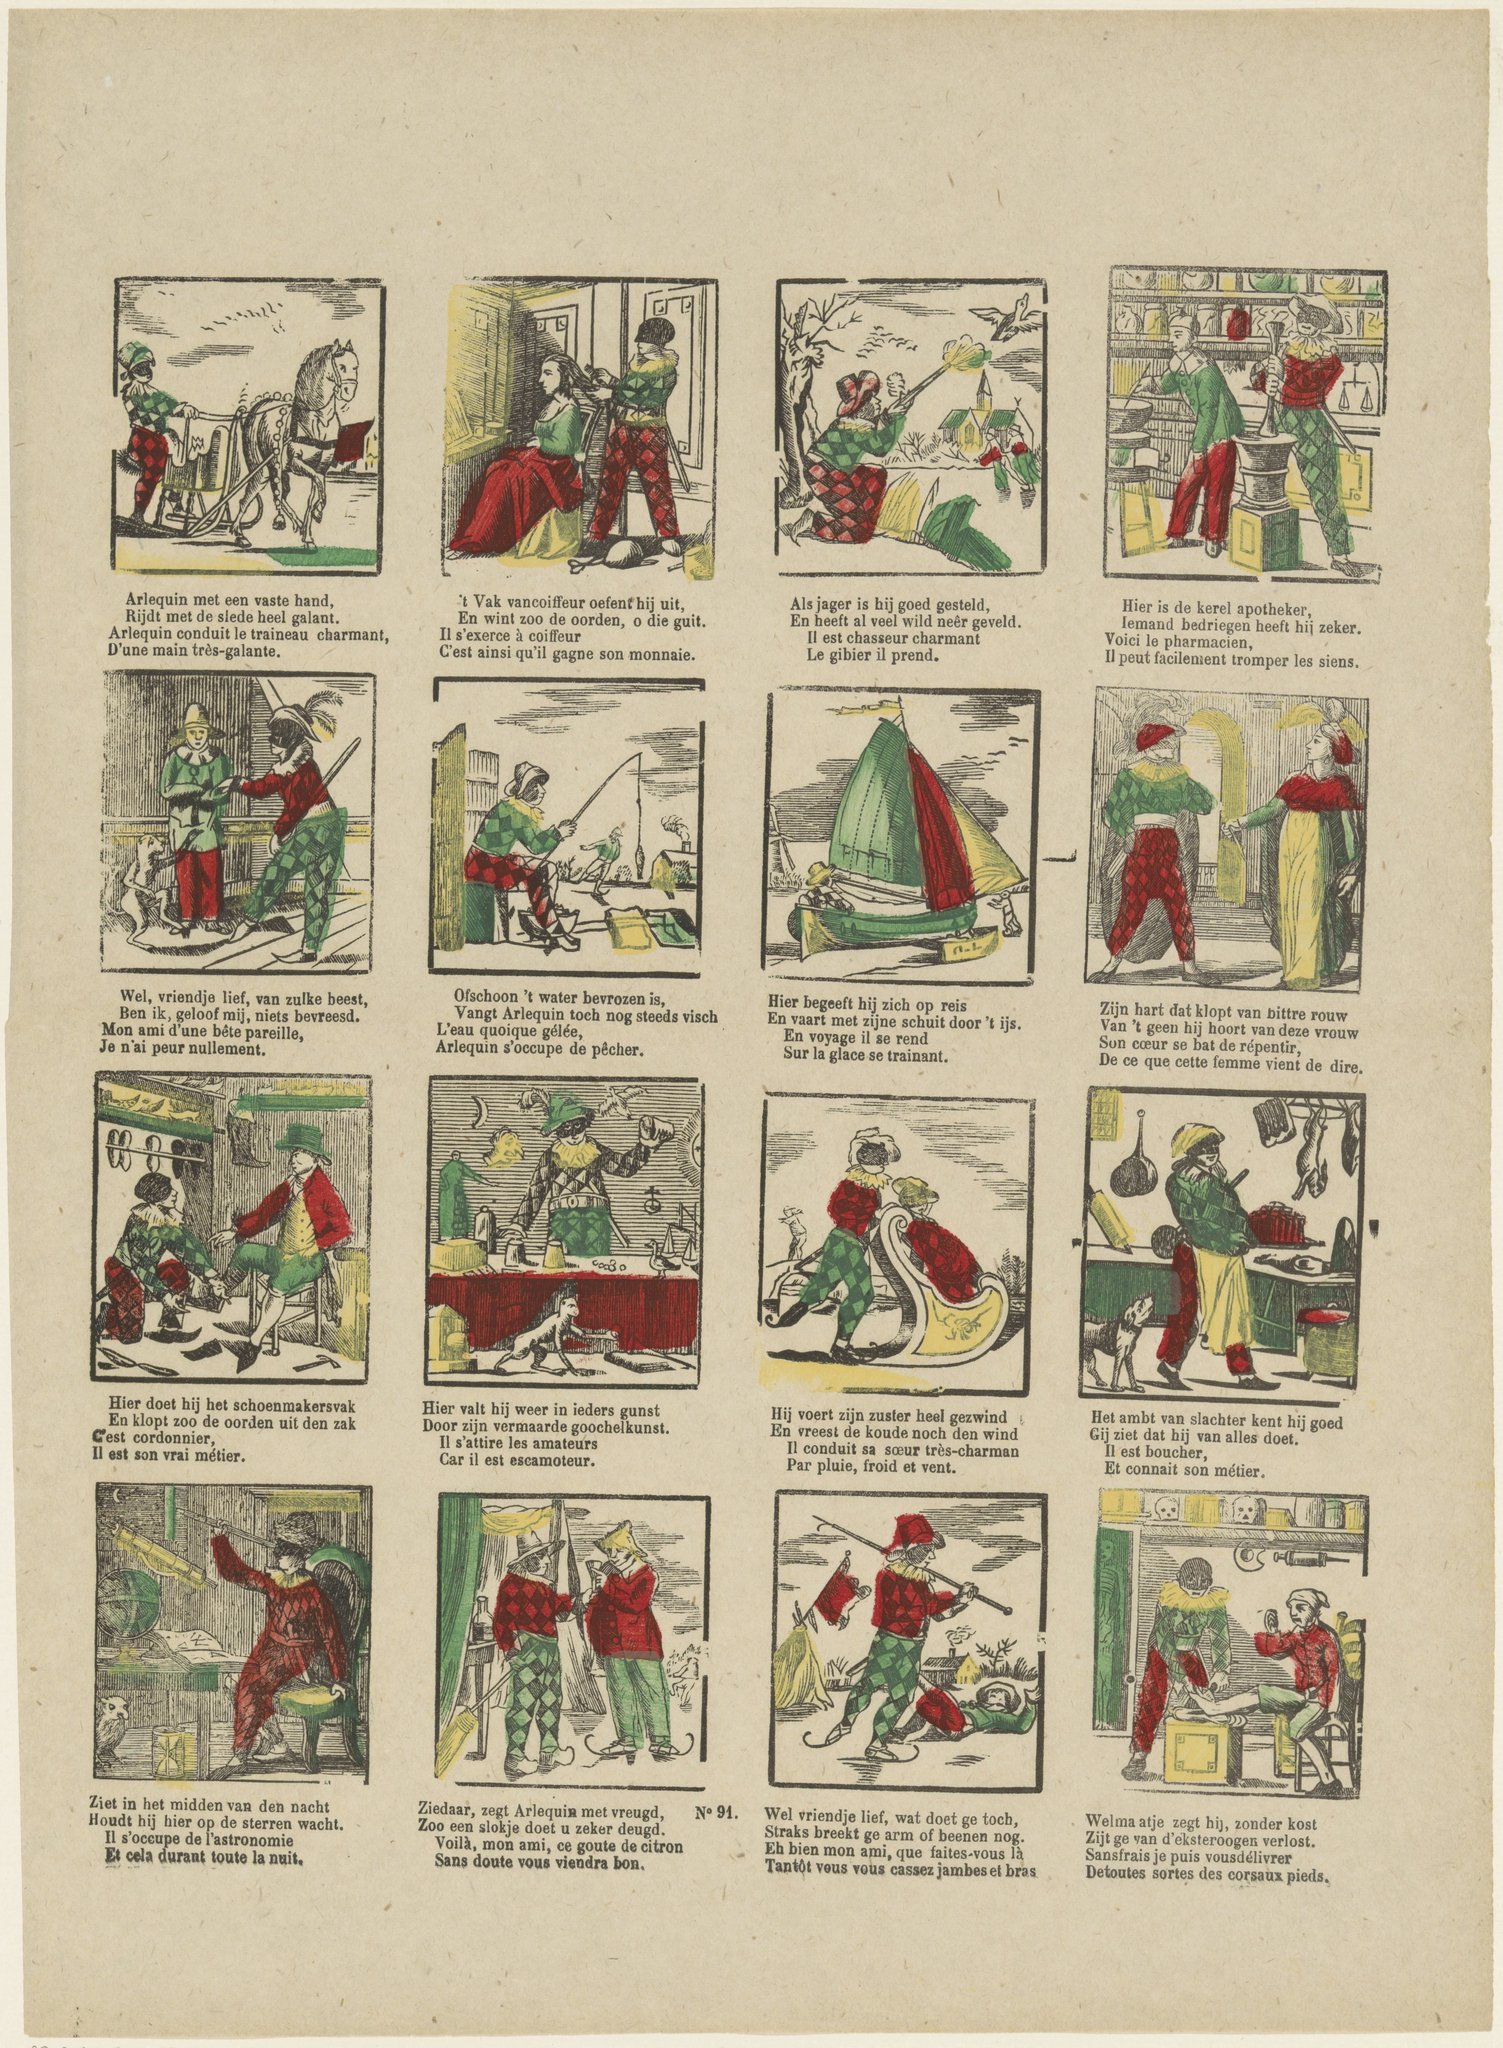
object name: print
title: Harlekijn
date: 1866-1902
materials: paper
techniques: colour, letterpress printing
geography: turnhout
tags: types in 'commedia dell'arte': harlequin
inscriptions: collector's mark: Lugt 2760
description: Blad met 16 voorstellingen over het leven van Harlekijn. Onder elke afbeelding een tweeregelig vers in het Nederlands en in het Frans. Genummerd midden onder: No 91.